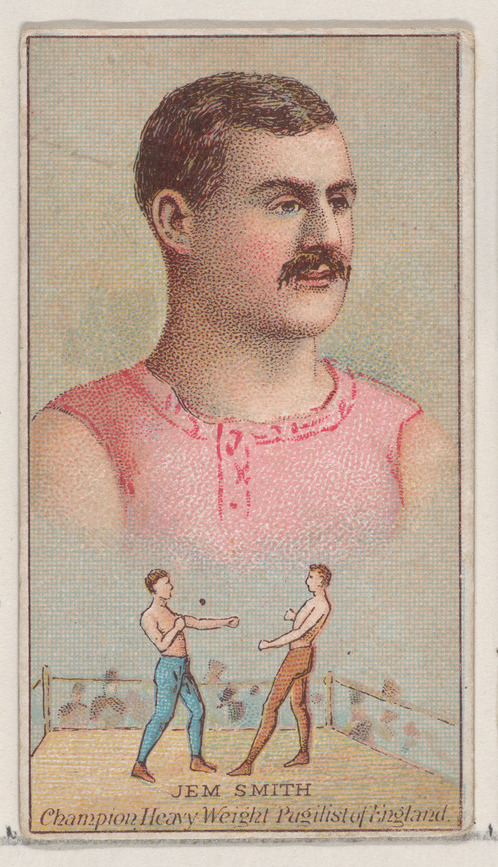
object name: print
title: Jem Smith, Champion Heavy Weight Pugilist of England, from the Champions of Games and Sports series (N184, Type 2) issued by W.S. Kimball & Co.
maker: w.s. kimball & co.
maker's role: publisher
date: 1887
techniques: color lithograph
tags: men,boxing,athletes